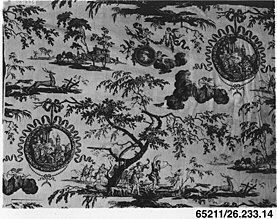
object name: furnishing textile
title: "Diane Chasseresse"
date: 1767-1800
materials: cotton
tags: deer,trees